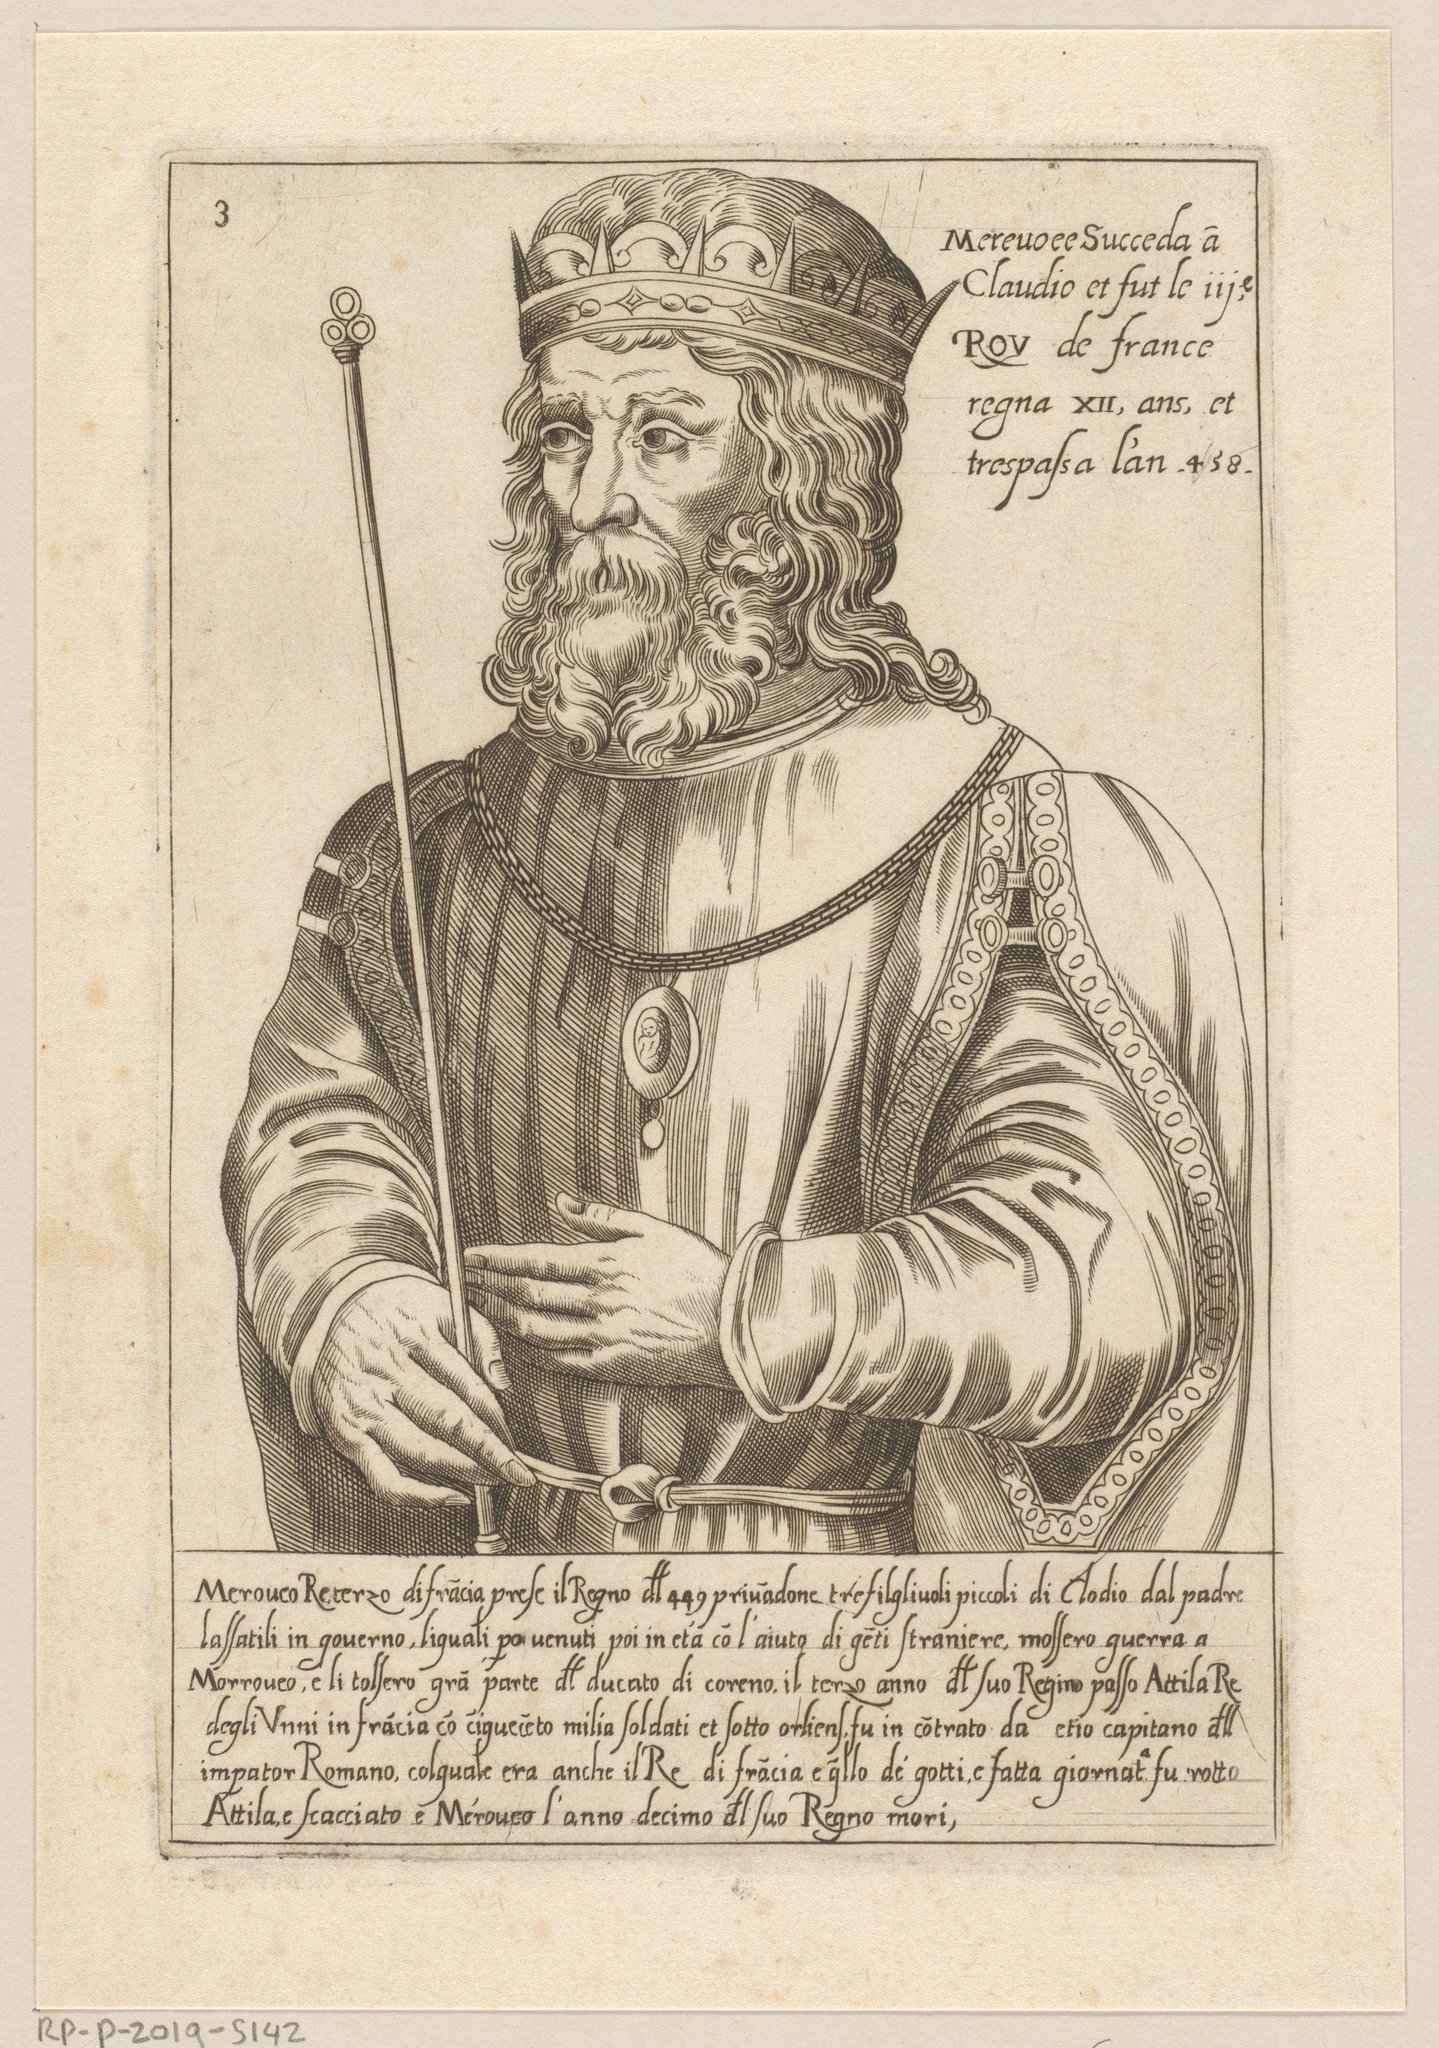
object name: book illustration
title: Portret van Merovech, koning der Franken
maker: Anonymous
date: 1588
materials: paper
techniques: engraving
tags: crown (symbol of sovereignty), sceptre, staff (symbol of sovereignty), historical persons, king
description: Prent voor het eerst gebruikt in: Cronica Breve de i fatti illustri de're di Francia, con le loro effigie dal naturale cominciando da Faramondo (...). Venetië: Bernardo Giunti, 1588. Prent in ieder geval ook gebruikt in de editie van 1590 en mogelijk ook in een Franse uitgave van 1597.